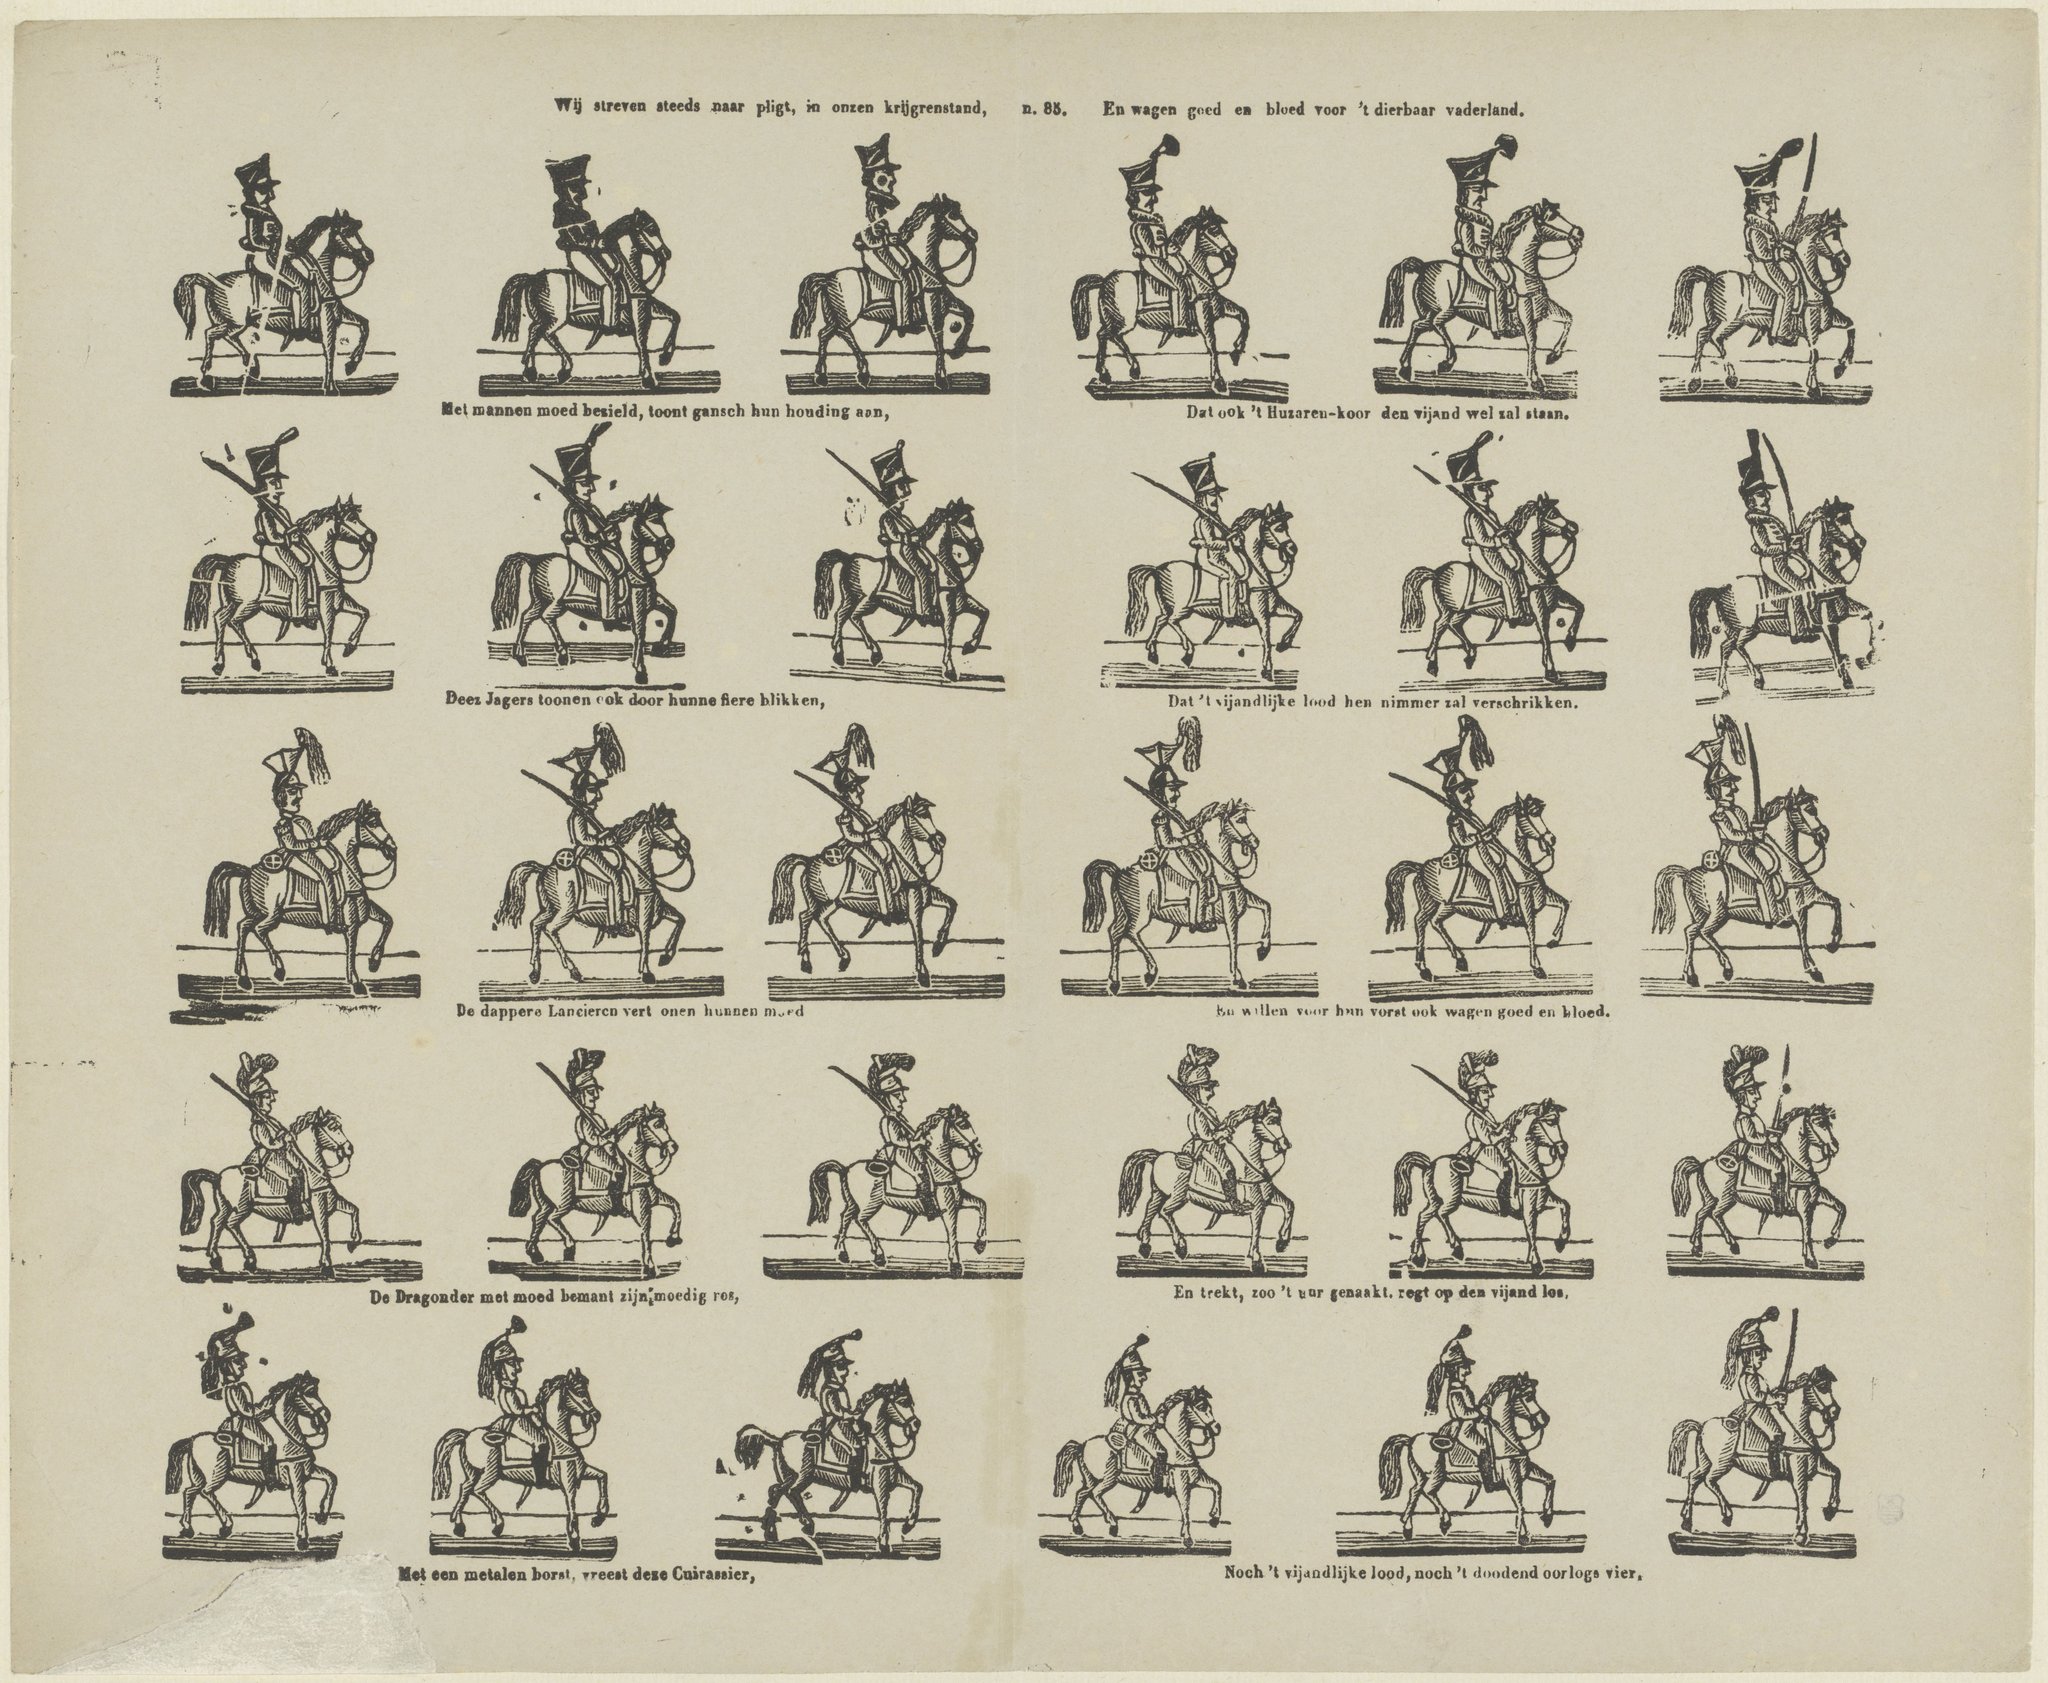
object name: print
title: Wij streven steeds naer pligt, in onzen krijgrenstand, / En wagen goed en bloed voor 't dierbaar vaderland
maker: Anonymous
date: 1856-1900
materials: paper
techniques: letterpress printing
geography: turnhout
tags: warfare; military affairs (+ cavalry, horsemen)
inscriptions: collector's mark: Lugt 2760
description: Blad met 30 voorstellingen van militairen te paard. Onder elke rij een onderschrift. Genummerd midden boven: n. 85.